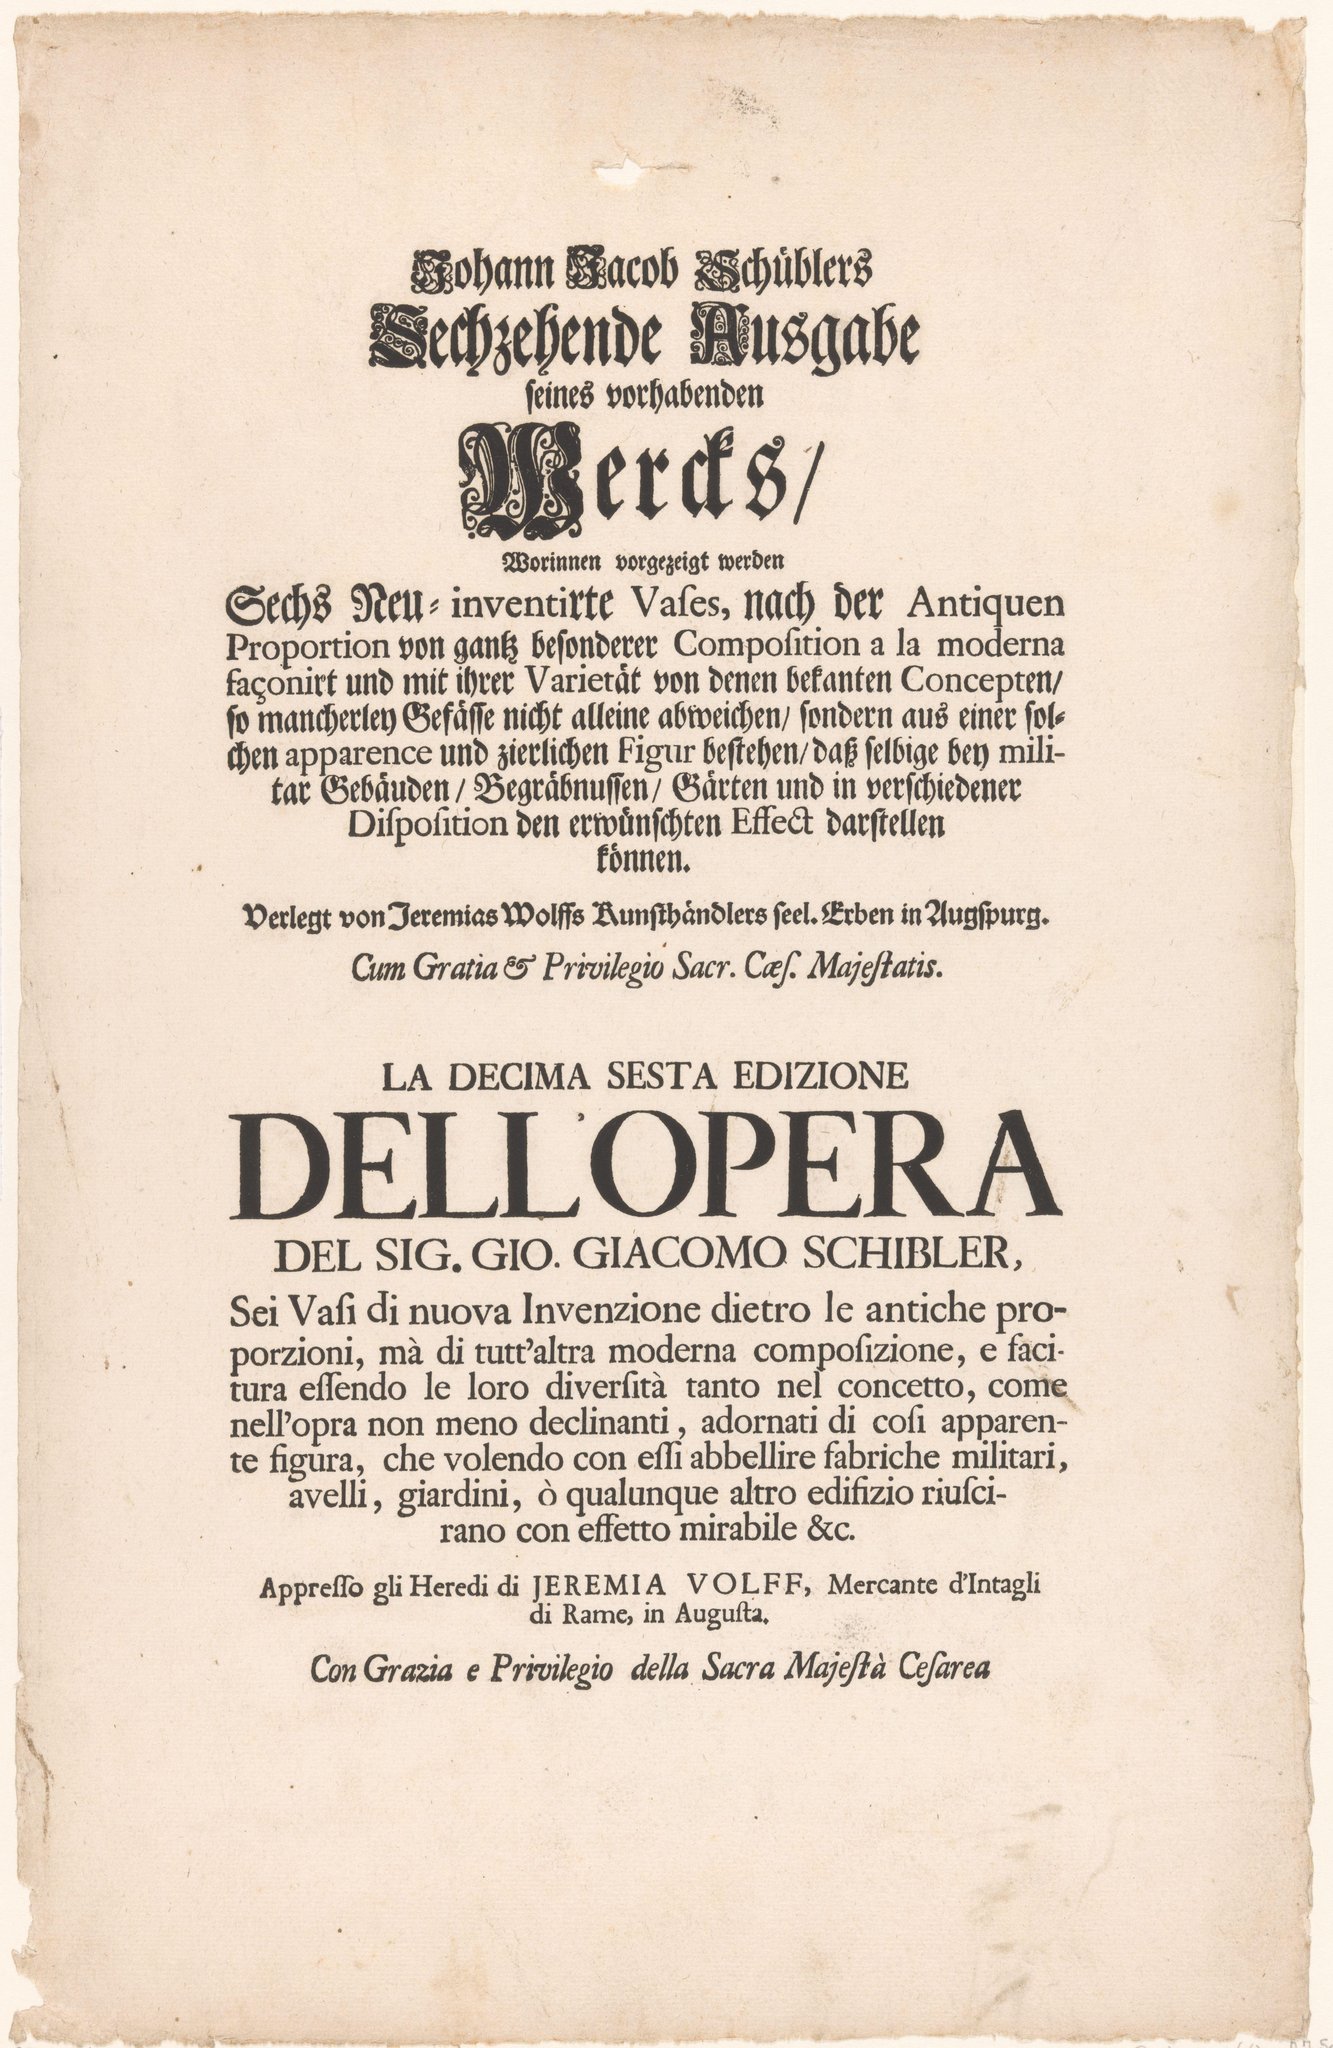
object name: print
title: Johann Jacob Schüblers Sechzehende Ausgabe seines vorhabenden Wercks, Worinnen vorgezeigt werden Sechs Neu-inventirte Vases (...)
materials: paper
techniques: letterpress printing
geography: augsburg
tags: title-page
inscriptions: collector's mark: Lugt 2228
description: Prent uit: Schübler, Johann Jacob. Erste [-Zwanzigste] Ausgabe seines vorhabenden Wercks (...). Augsburg: Wolf, erven Jeremias, [na 1724]